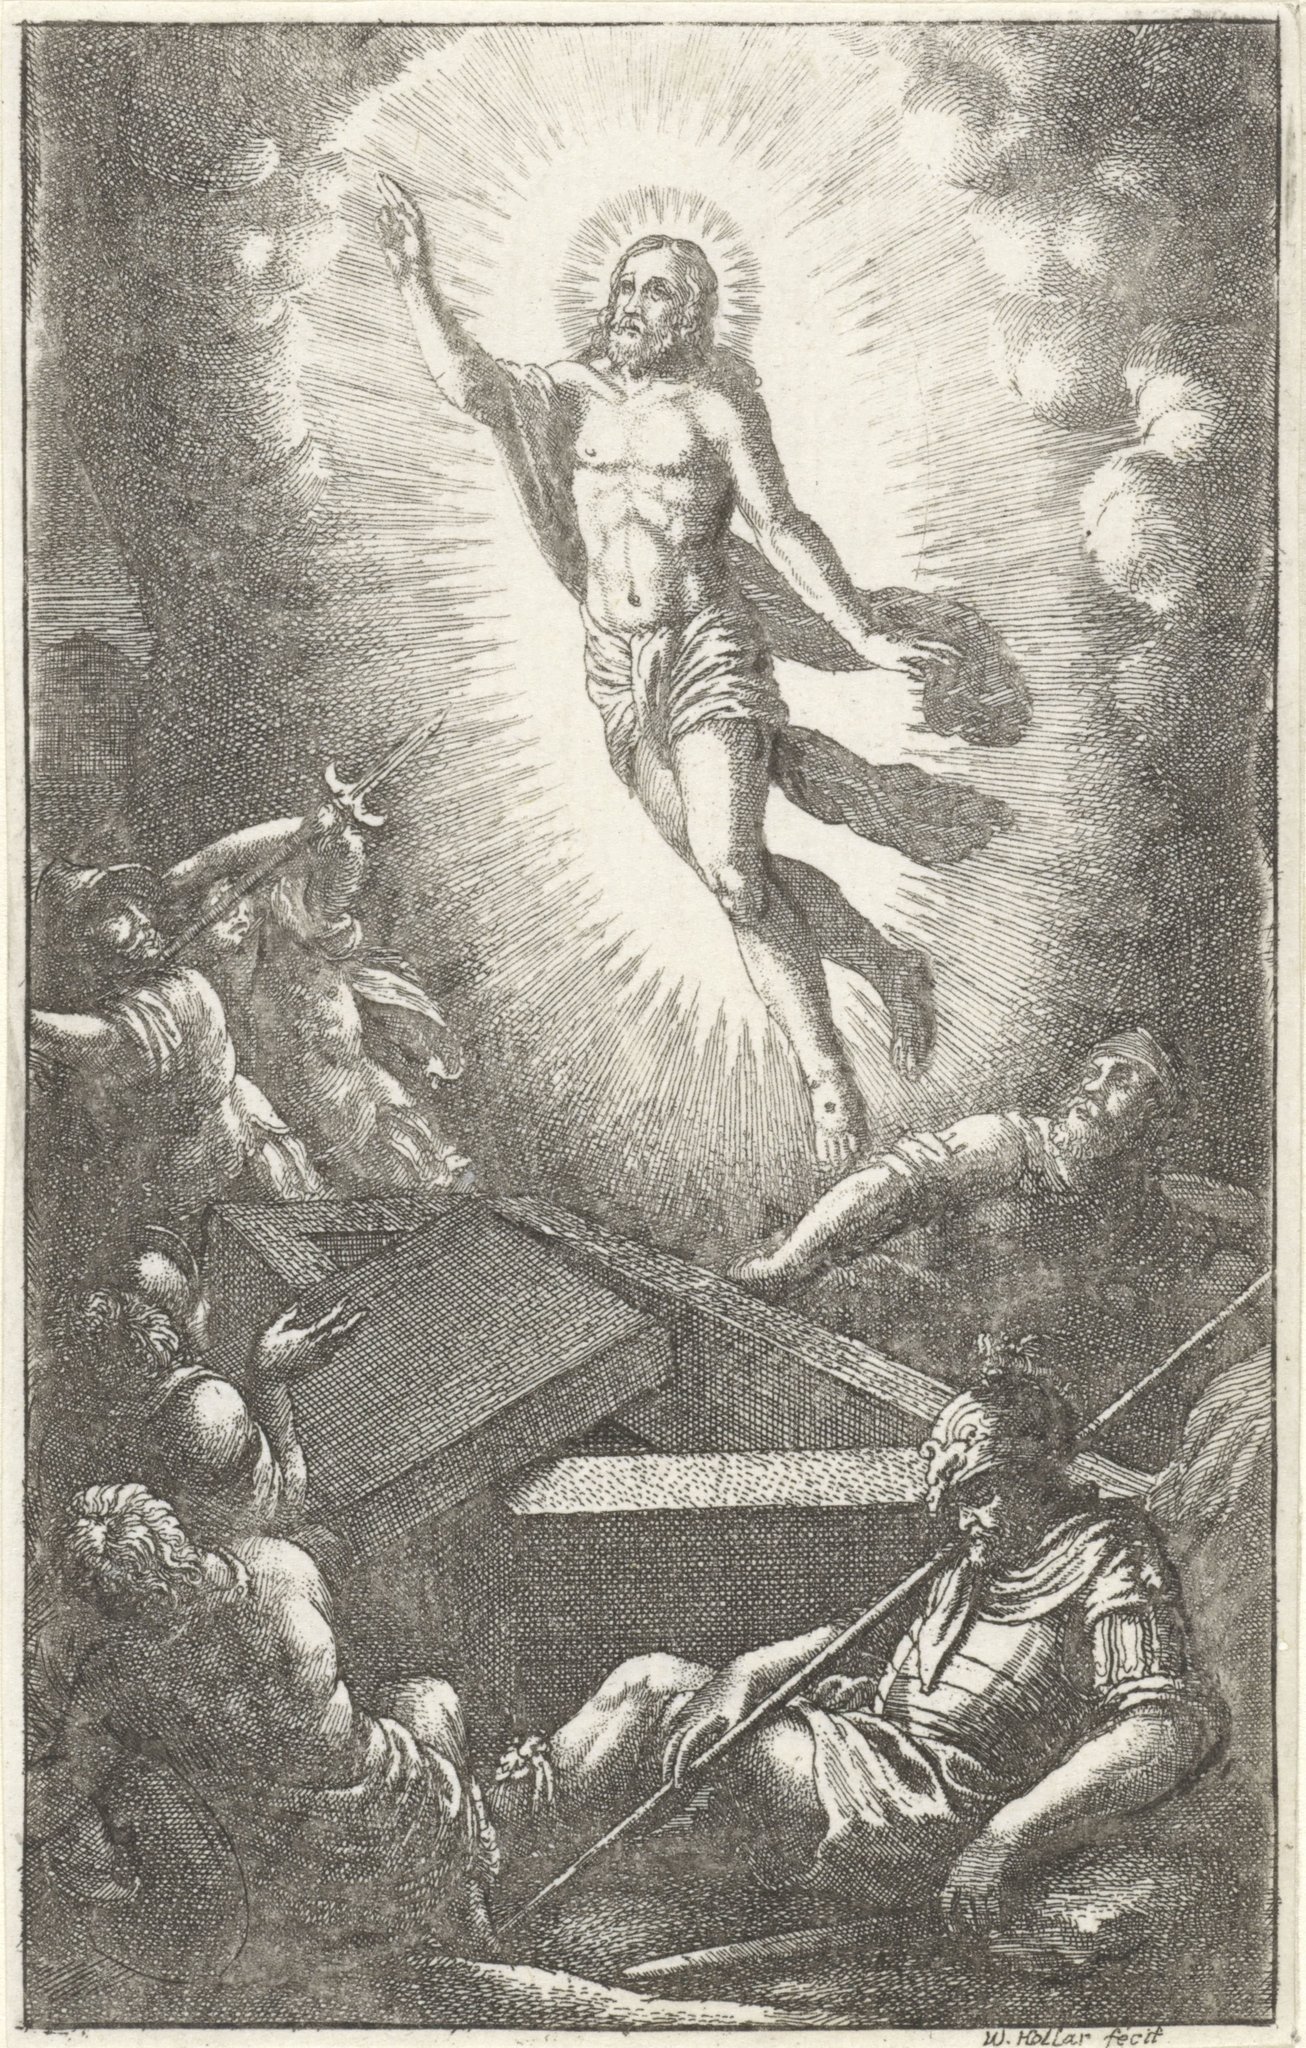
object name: book illustration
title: Passie van Christus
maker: wenceslaus hollar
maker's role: draughtsman, print maker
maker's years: 1607-1677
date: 1670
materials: paper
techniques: etching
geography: london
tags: christ, usually holding a banner, arises from the grave; often combined with sleeping and/or frightened soldiers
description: Prent opgenomen in: The Office Of The Holy Week According To The Missall And Roman Breviary. Printed by the Widow Chrestien, 1670, p. 486. Prent tevens opgenomen in latere uitgave: The Compleat Office of the Holy Week. Londen: Matthew Turner, 1687.